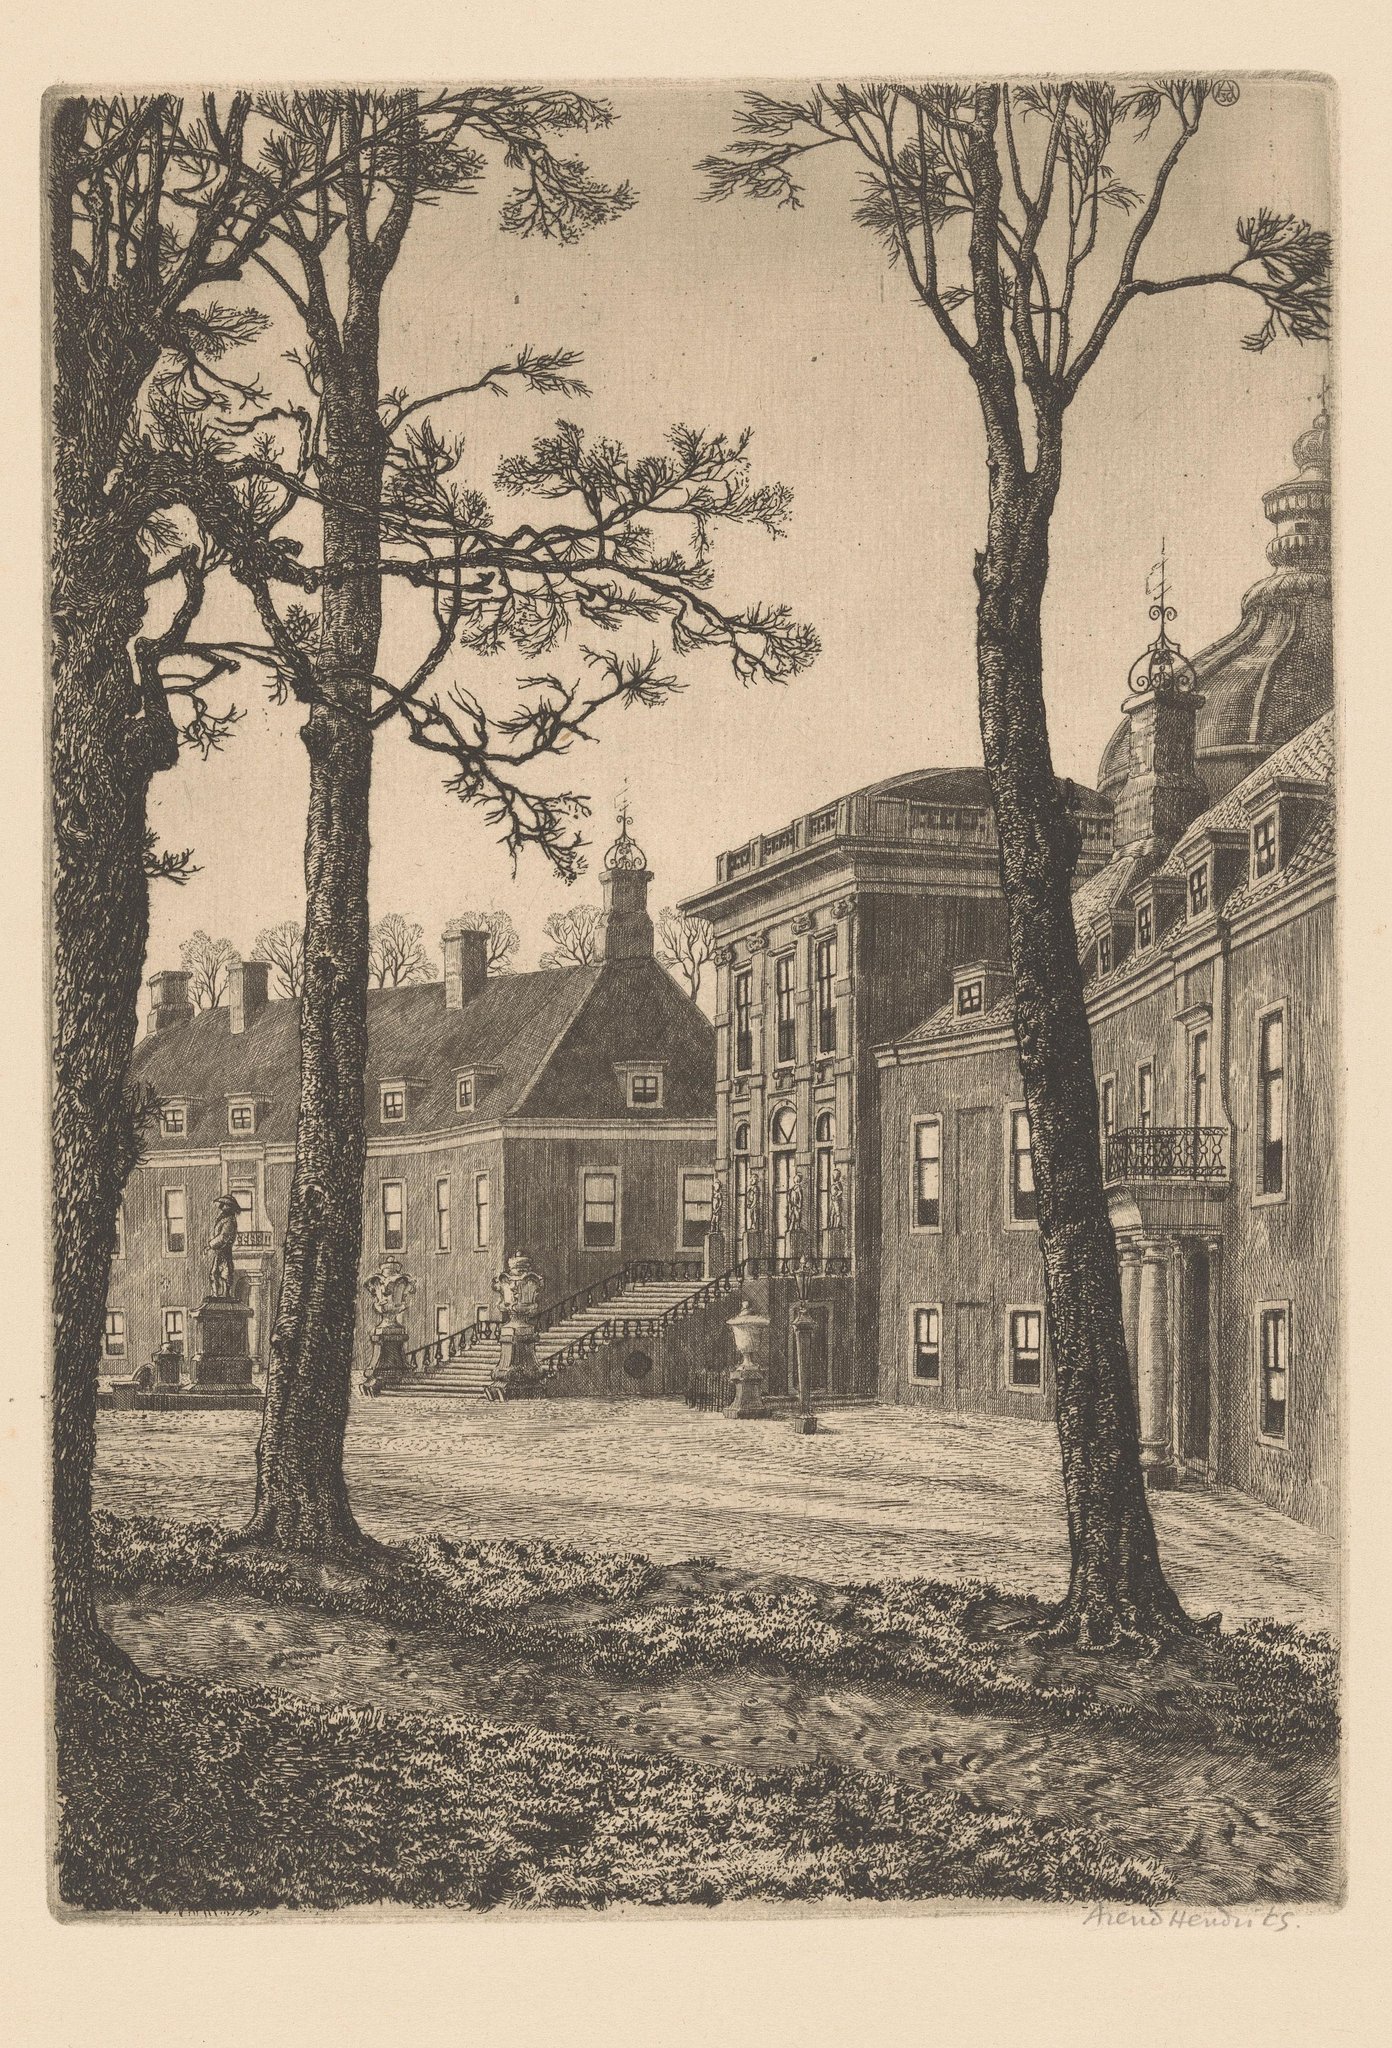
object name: print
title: Gezicht op Huis ten Bosch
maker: arend hendriks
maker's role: print maker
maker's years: 1901-1951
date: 1911-1951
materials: paper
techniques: etching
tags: palace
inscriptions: collector's mark: Lugt 2228